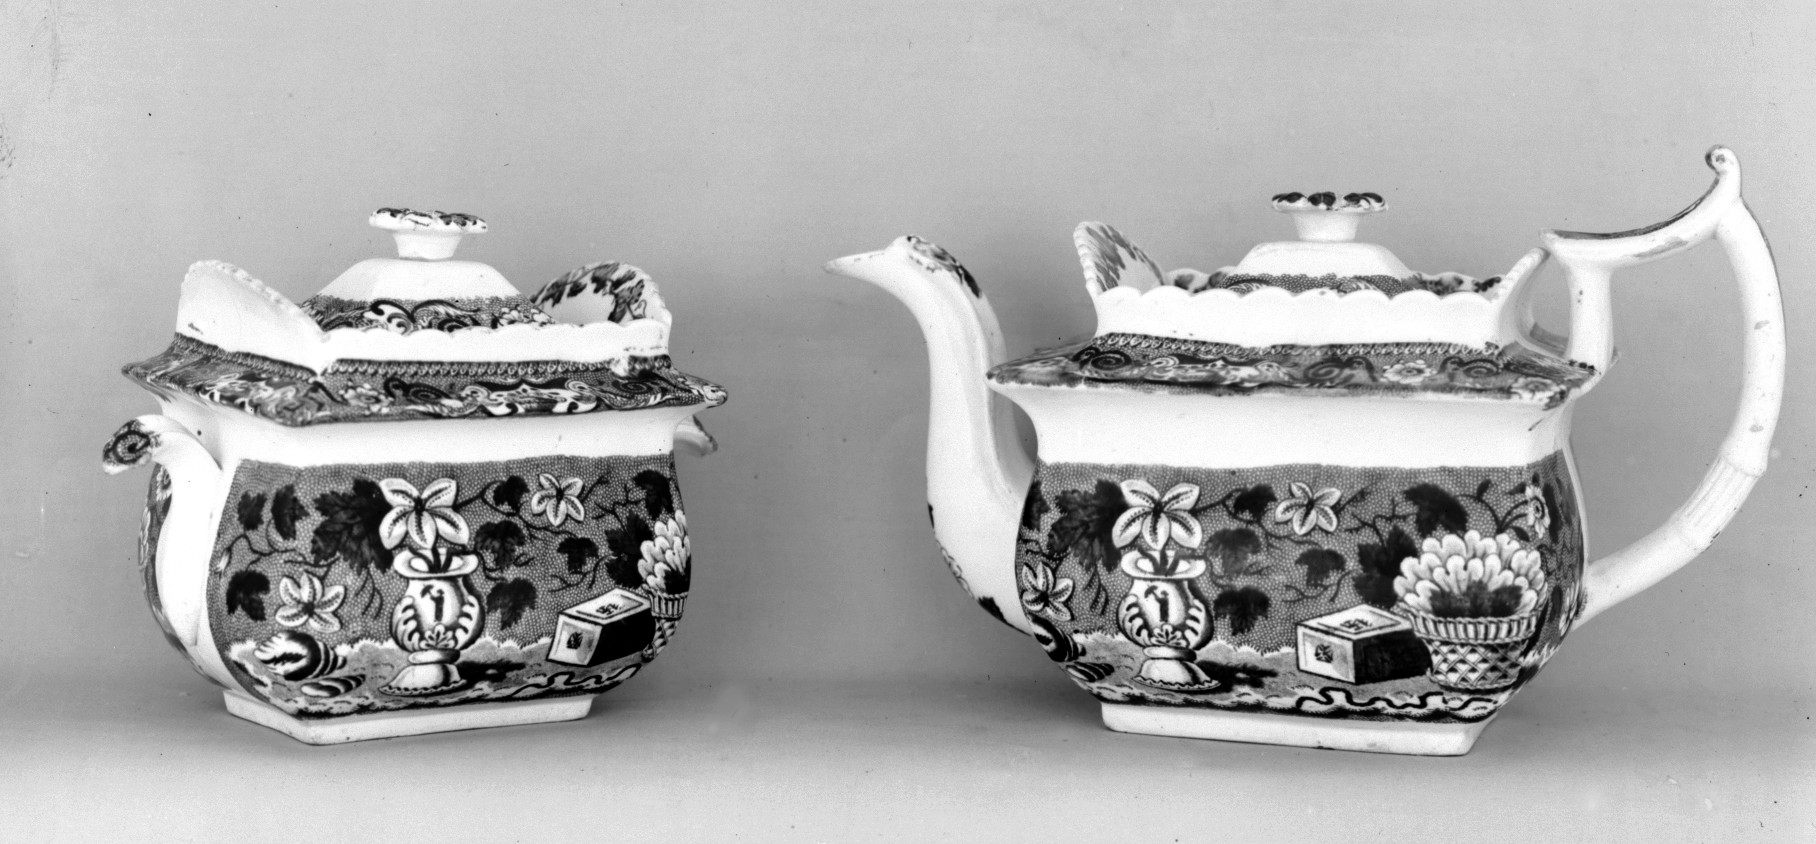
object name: sugar bowl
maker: james and ralph clews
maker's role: factory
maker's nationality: british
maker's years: 1813-1836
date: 1801-1900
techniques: printing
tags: flowers